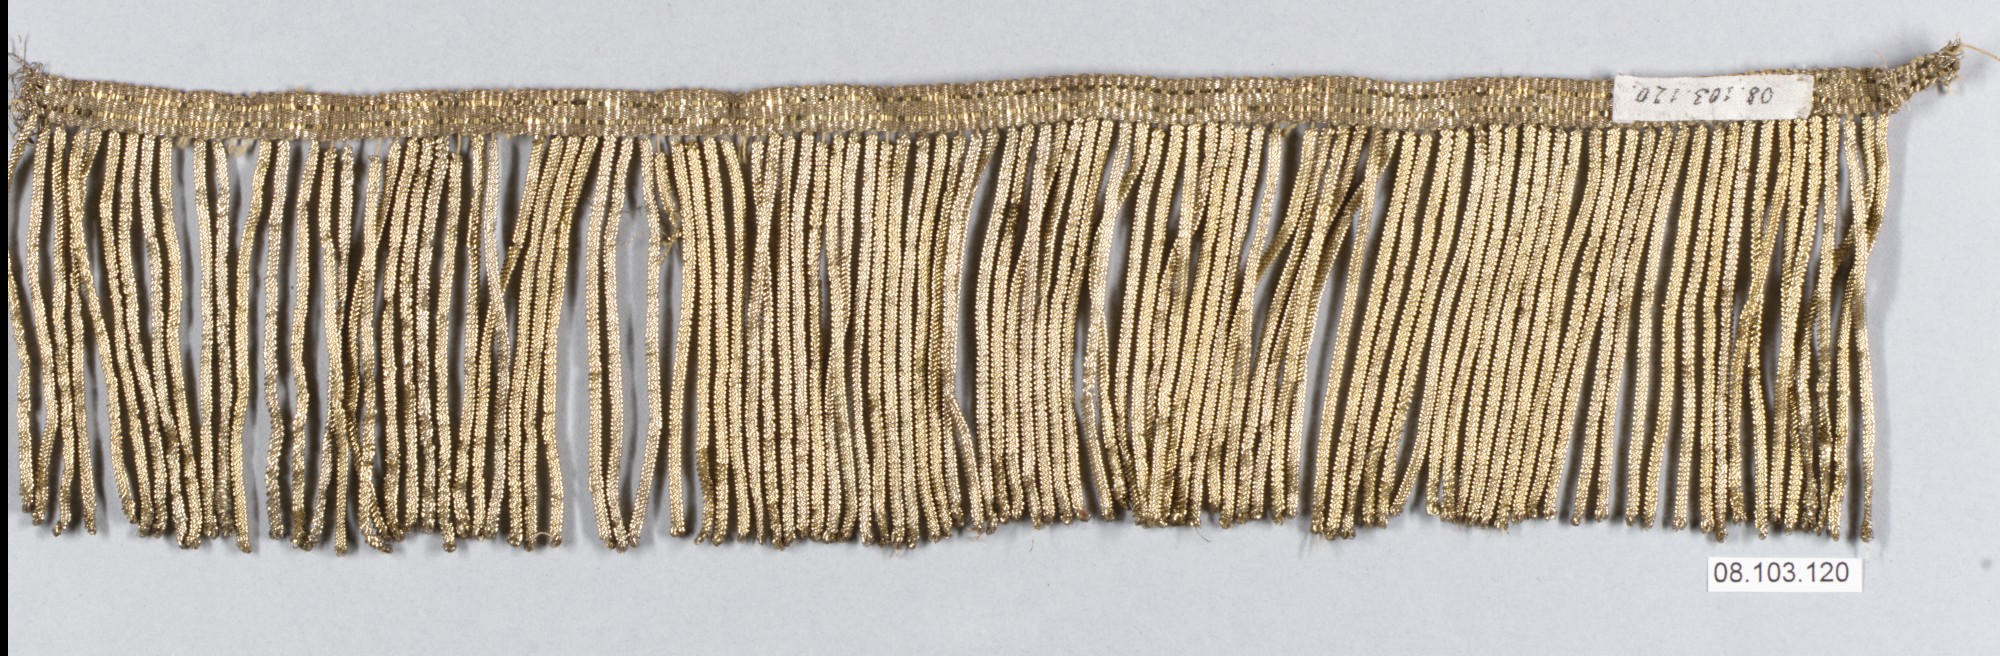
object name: fringe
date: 1801-1900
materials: metal thread